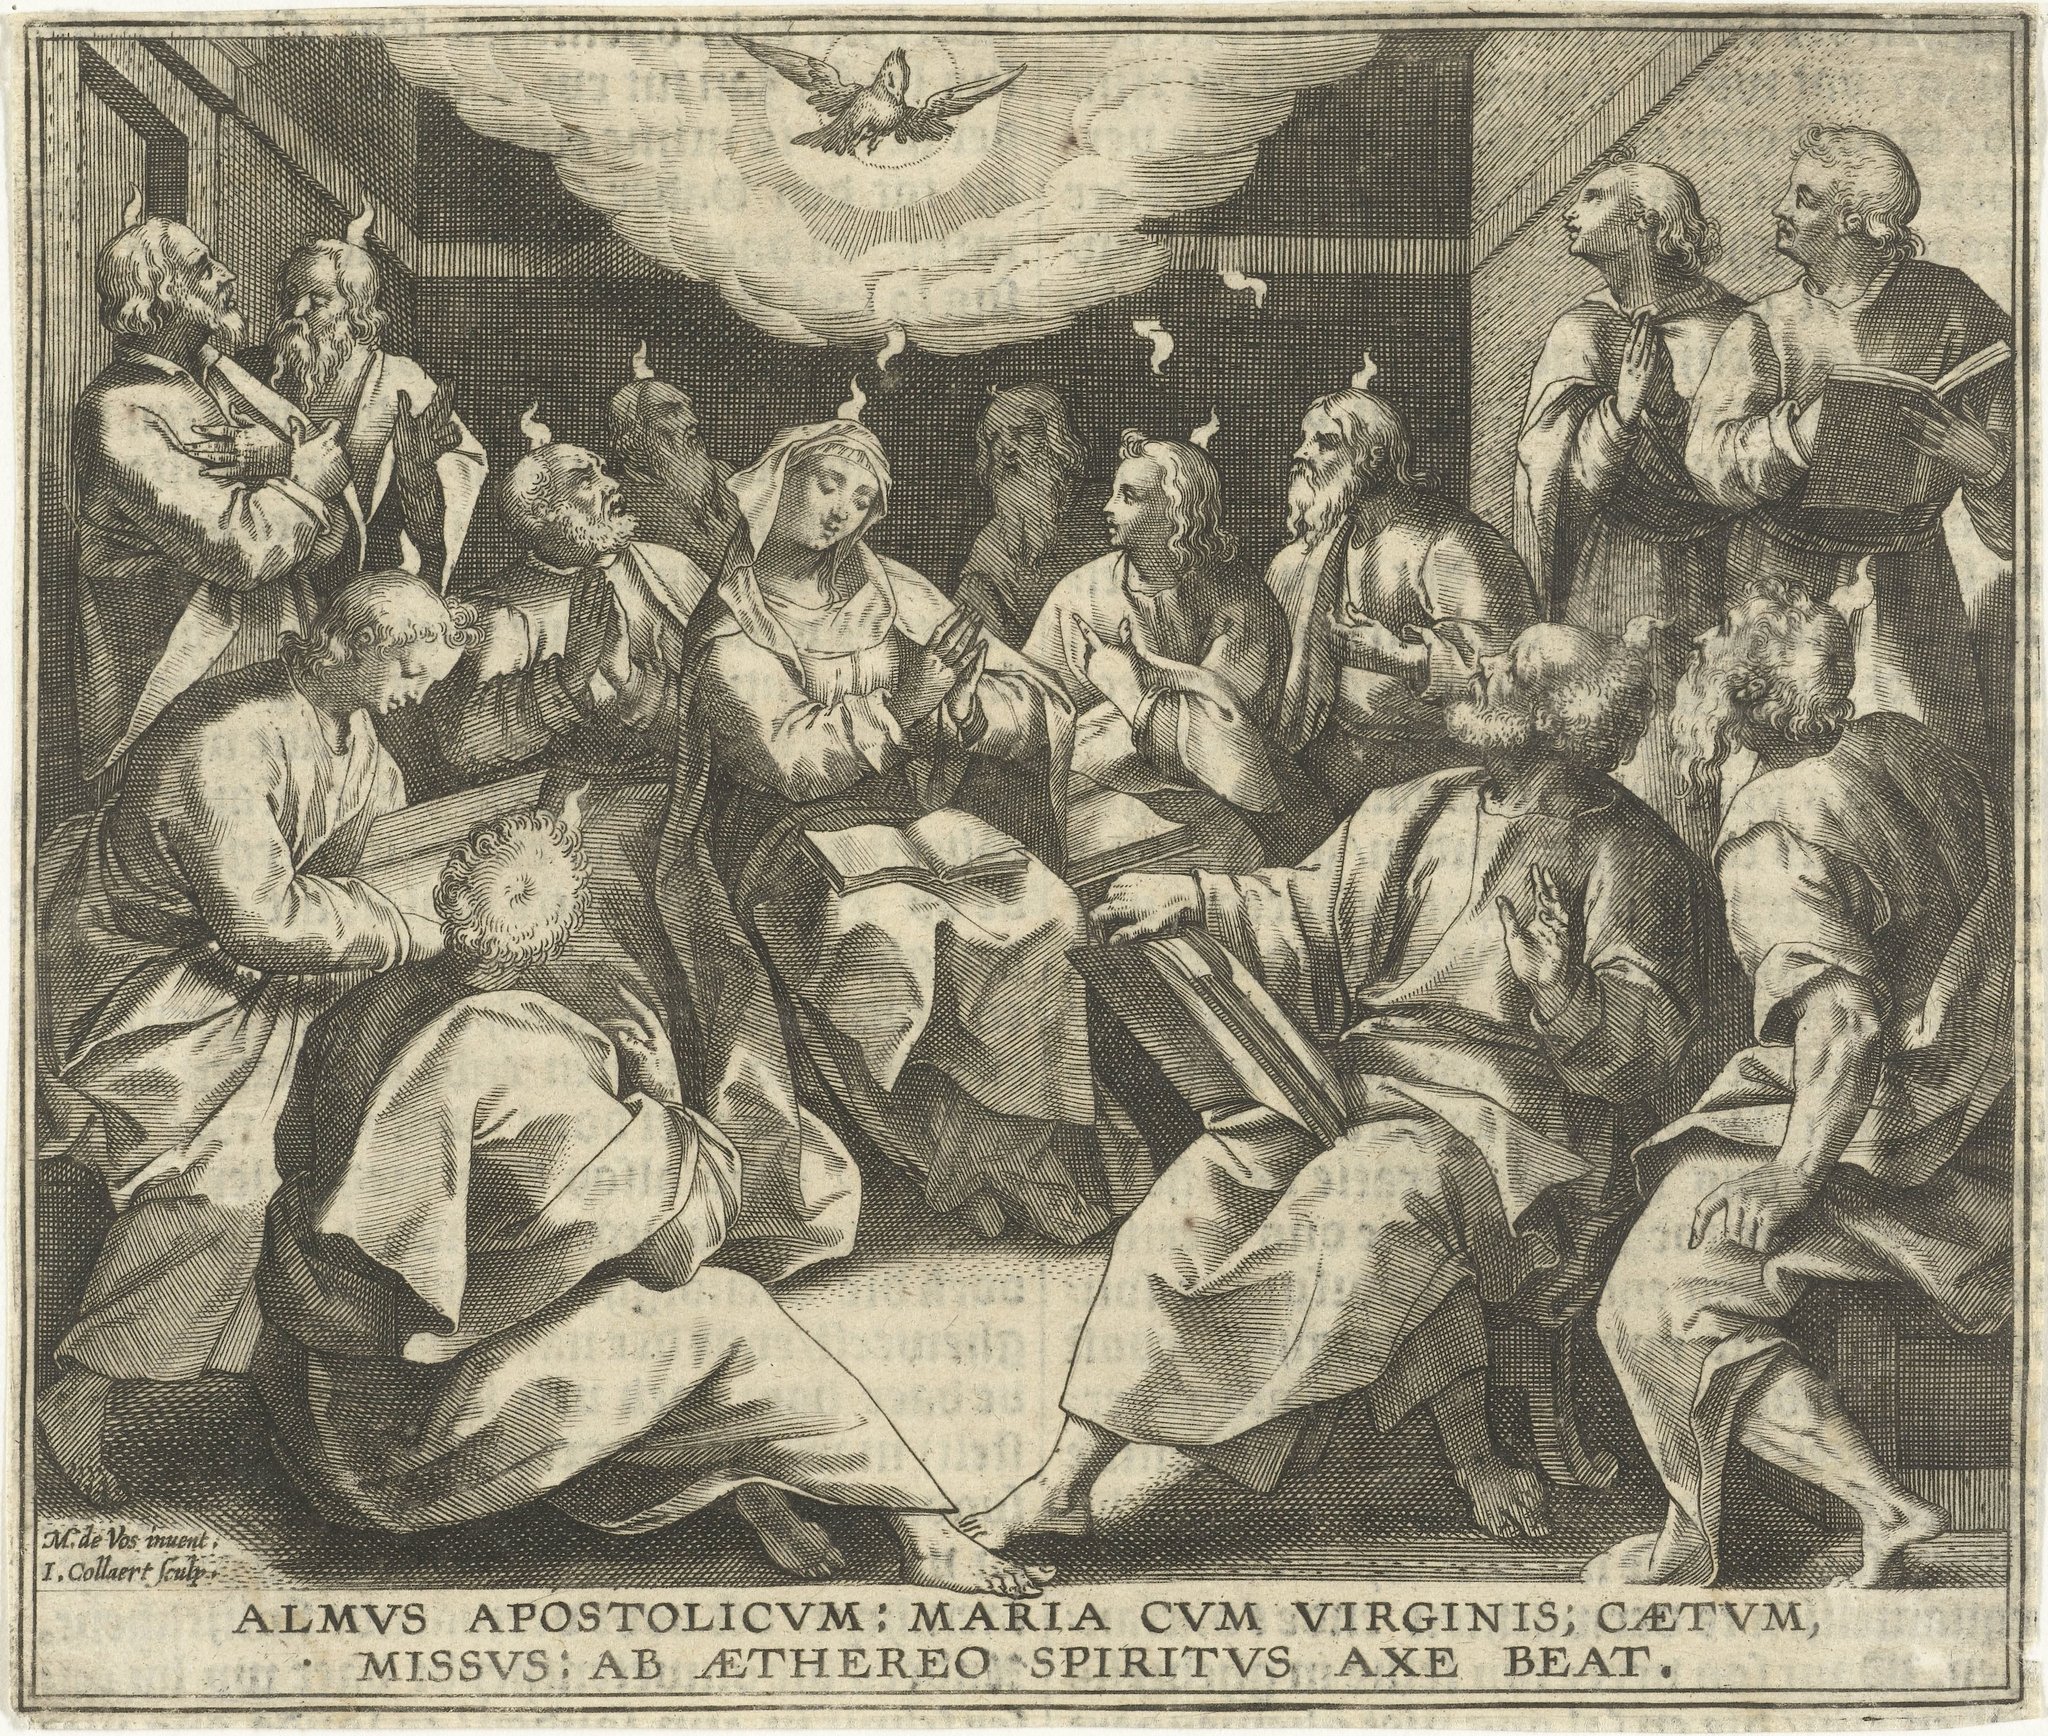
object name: print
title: Uitstorting van de Heilige Geest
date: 1597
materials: paper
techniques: engraving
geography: antwerp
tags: pentecost: the holy ghost descends upon (mary and) the apostles, sometimes paul and/or representatives of the nations present (acts 2:1-4)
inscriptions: collector's mark: Lugt 2228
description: Maria en de leerlingen van Christus zitten in een kamer te bidden. Temidden van de groep verschijnt de duif van de Heilige Geest. Boven de hoofden van de apostelen en Maria branden vurige tongen, tekens van de uitstorting van de Heilige Geest in hun hart. De prent heeft een Latijns onderschrift.